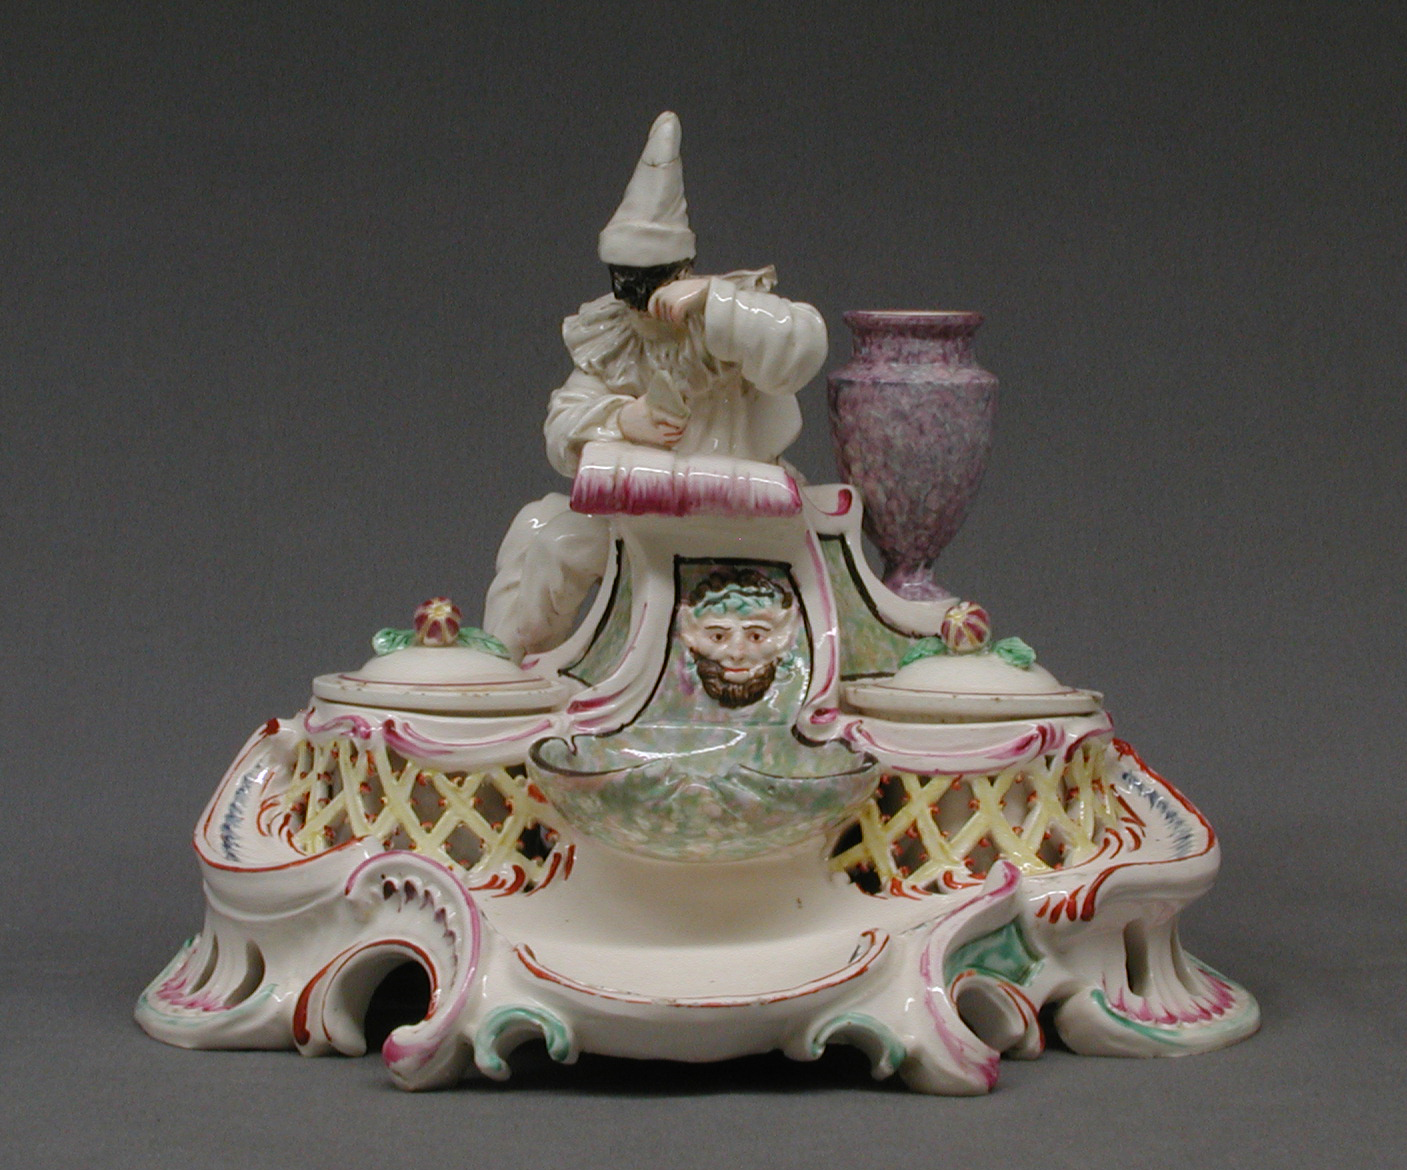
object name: inkstand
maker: royal porcelain manufactory, naples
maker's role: manufactory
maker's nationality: italian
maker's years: 1759-1819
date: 1765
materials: soft paste porcelain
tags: human figures,faces